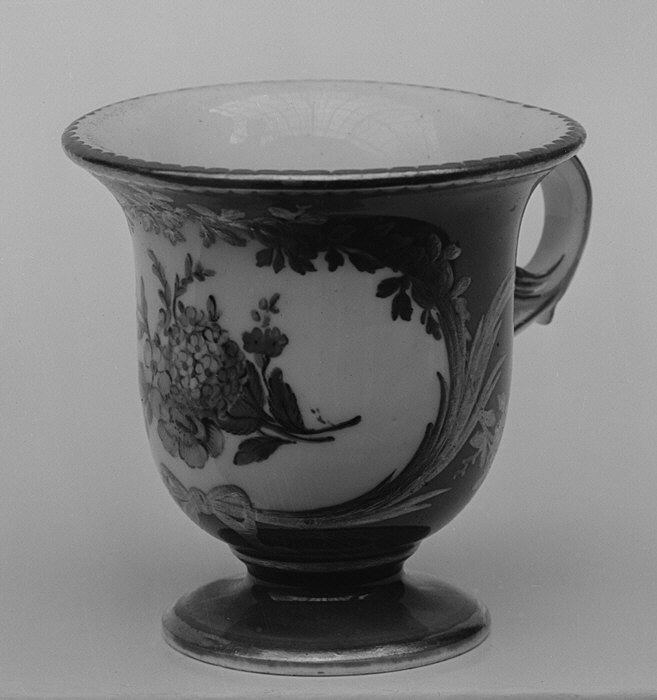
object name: ice cream cup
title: Ice cream cup (Tasse à glace) (part of a service)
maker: sèvres manufactory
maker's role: manufactory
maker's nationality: french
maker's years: 1740-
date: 1780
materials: soft paste porcelain